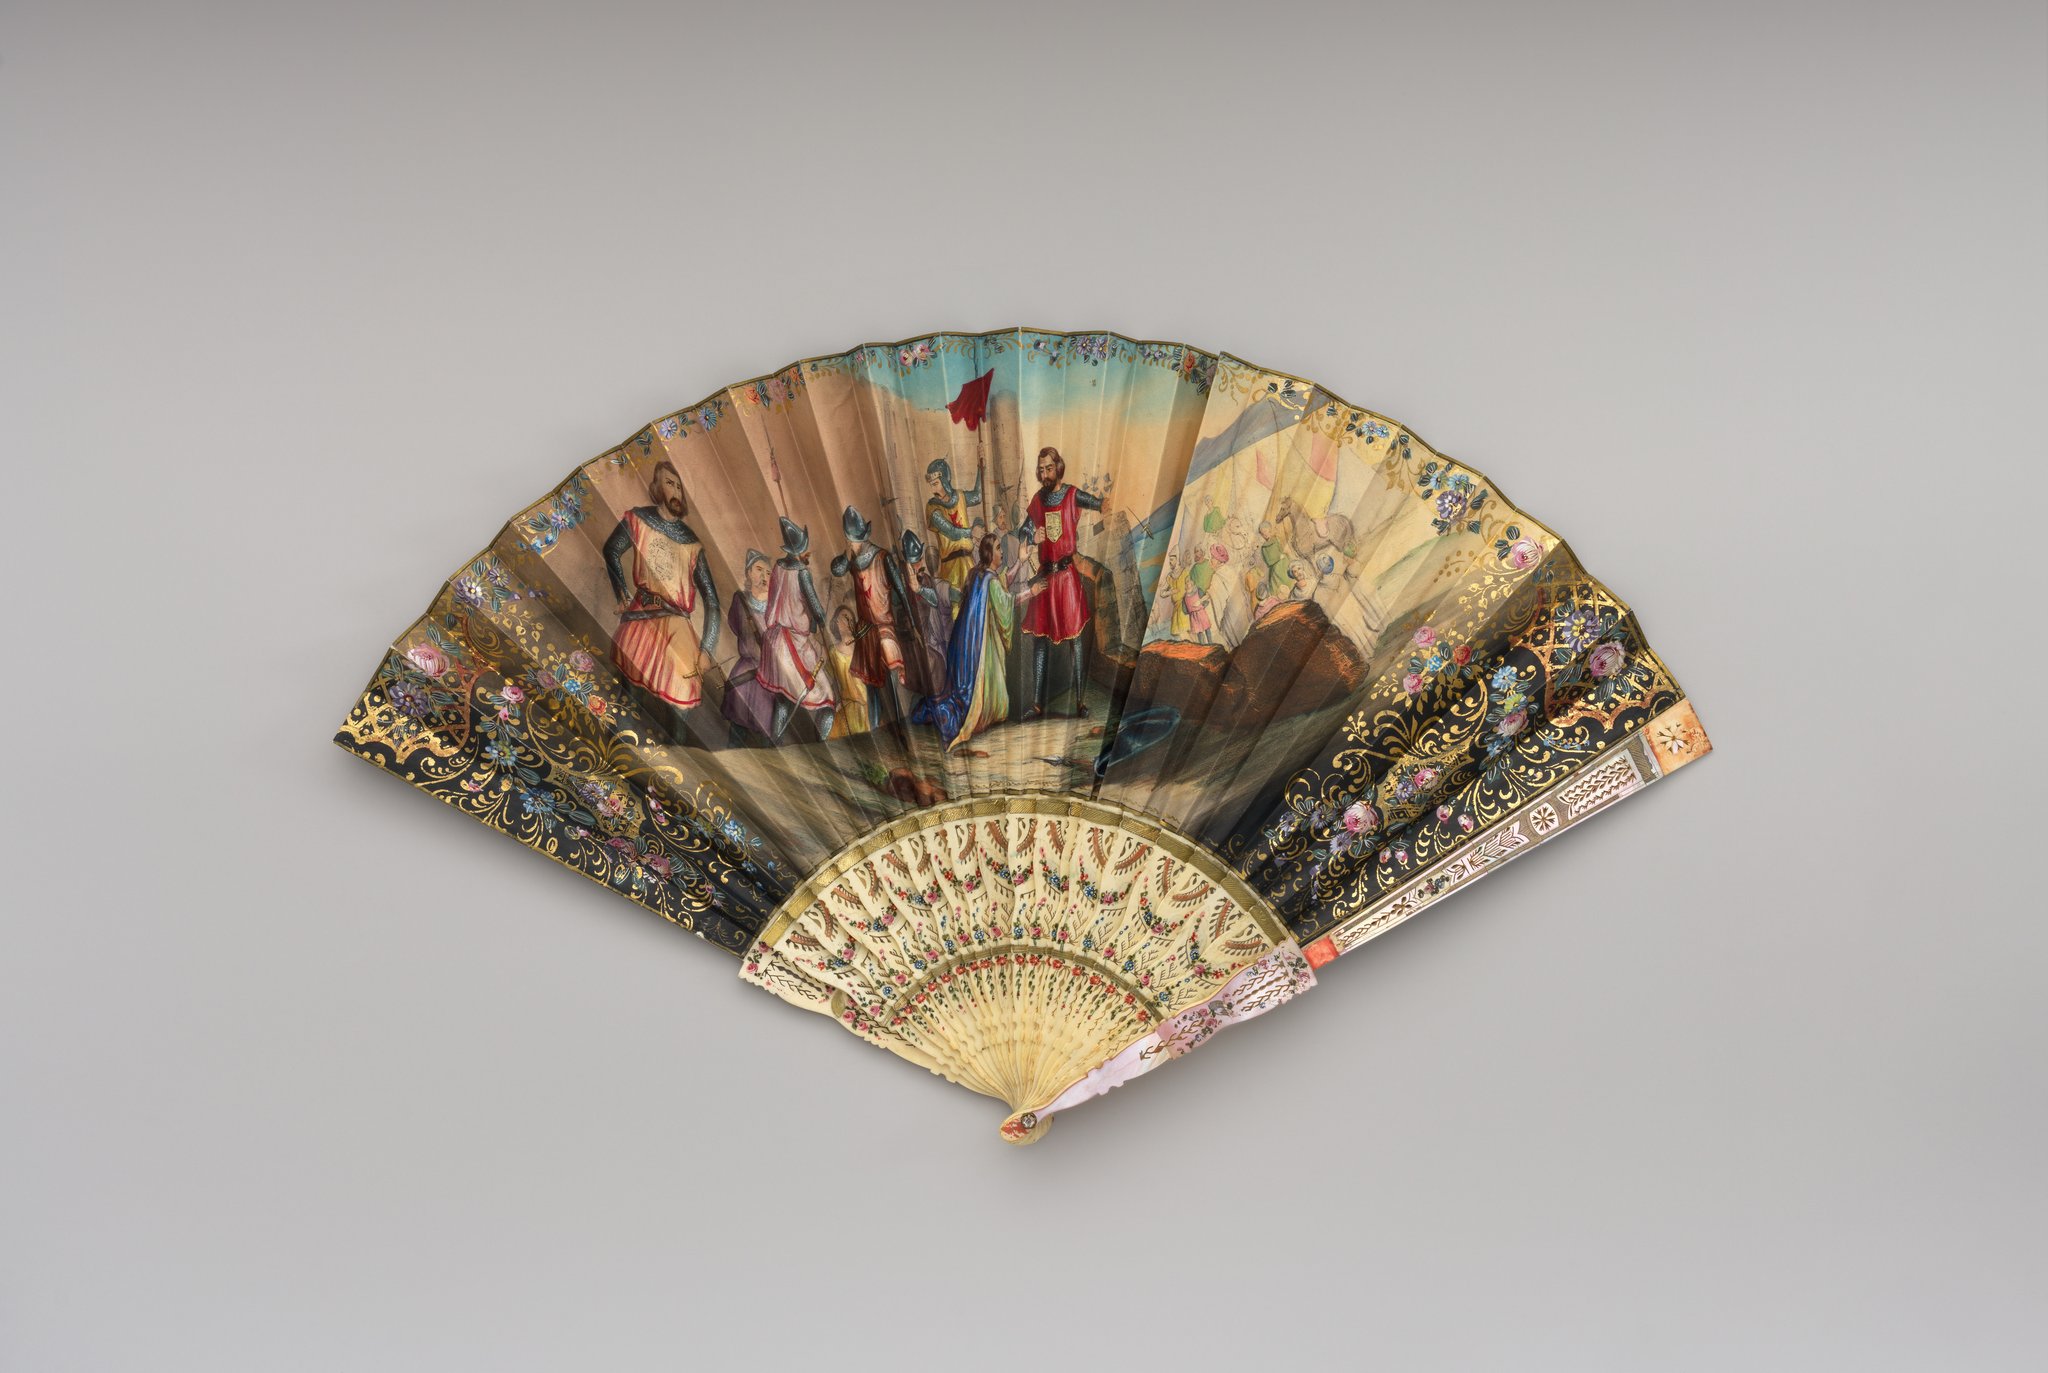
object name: fan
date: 1801-1900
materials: foil, gilt, glass, ivory, mother of pearl, paint, paper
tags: soldiers,men,women